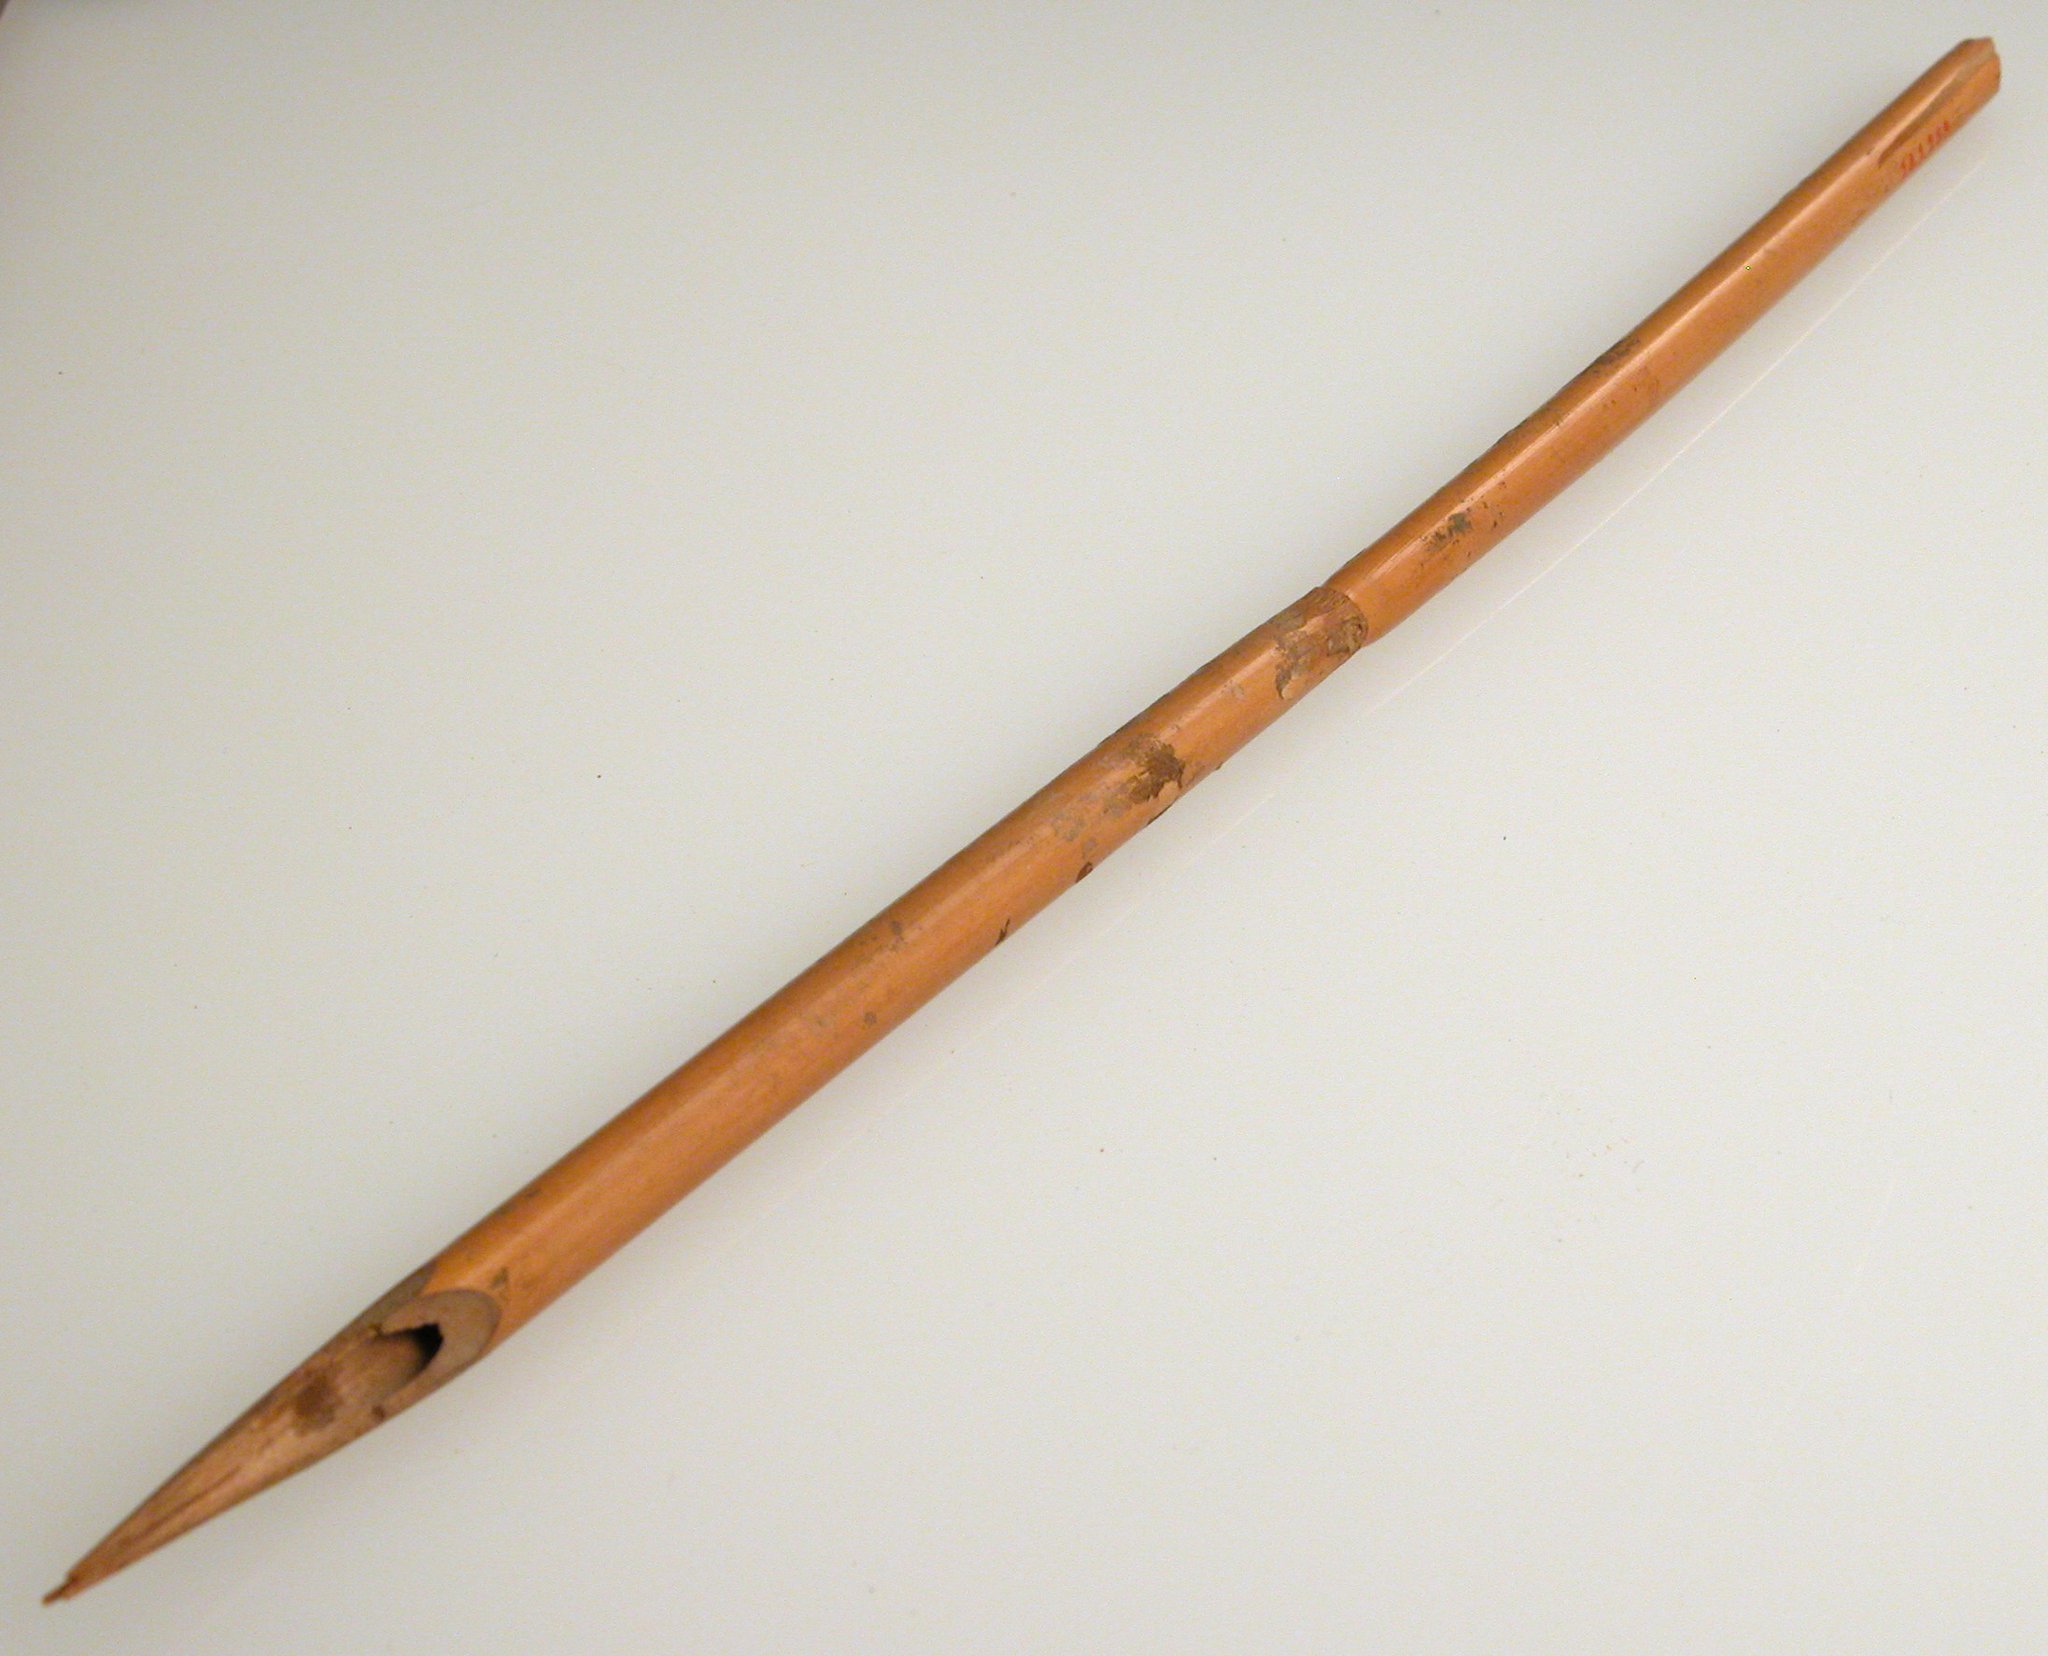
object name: pen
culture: coptic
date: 580-640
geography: egypt